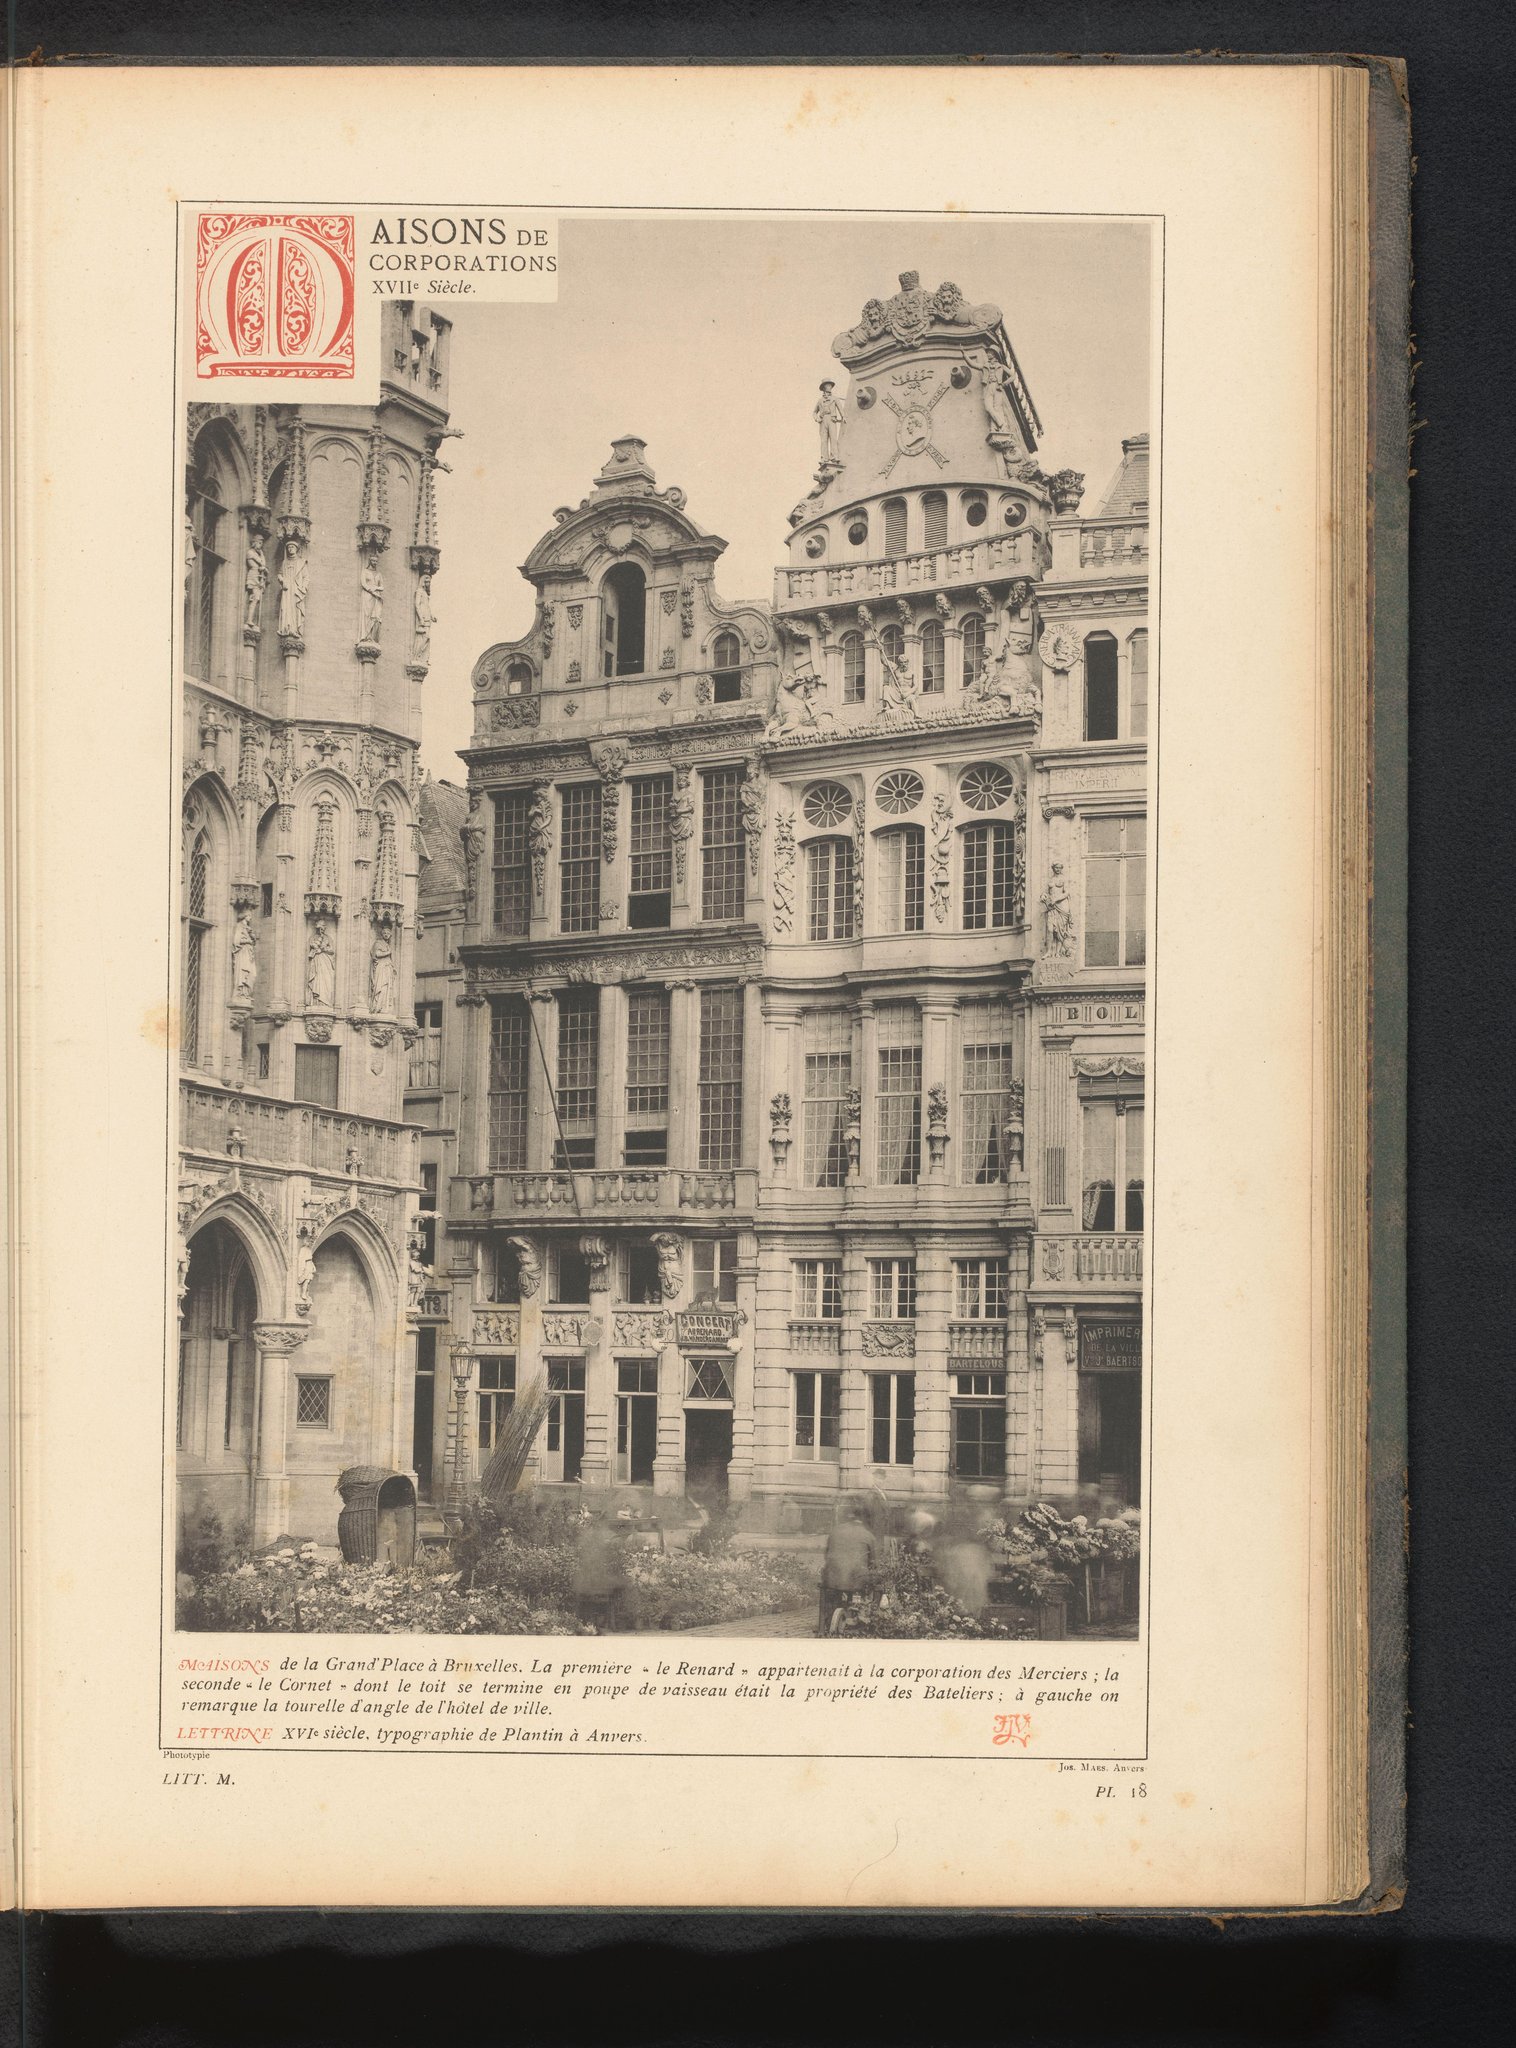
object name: photomechanical print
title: Gezicht op gildehuizen aan de Grote Markt in Brussel, België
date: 1875-1880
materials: paper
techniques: photograph, photolithography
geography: antwerp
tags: corporative organization, guild, civic architecture; edifices; dwellings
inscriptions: monogram: ‘JJvY’, inscription: ‘LITT. M. - PL. 18’, inscription: ‘MAISONS de la (...)’